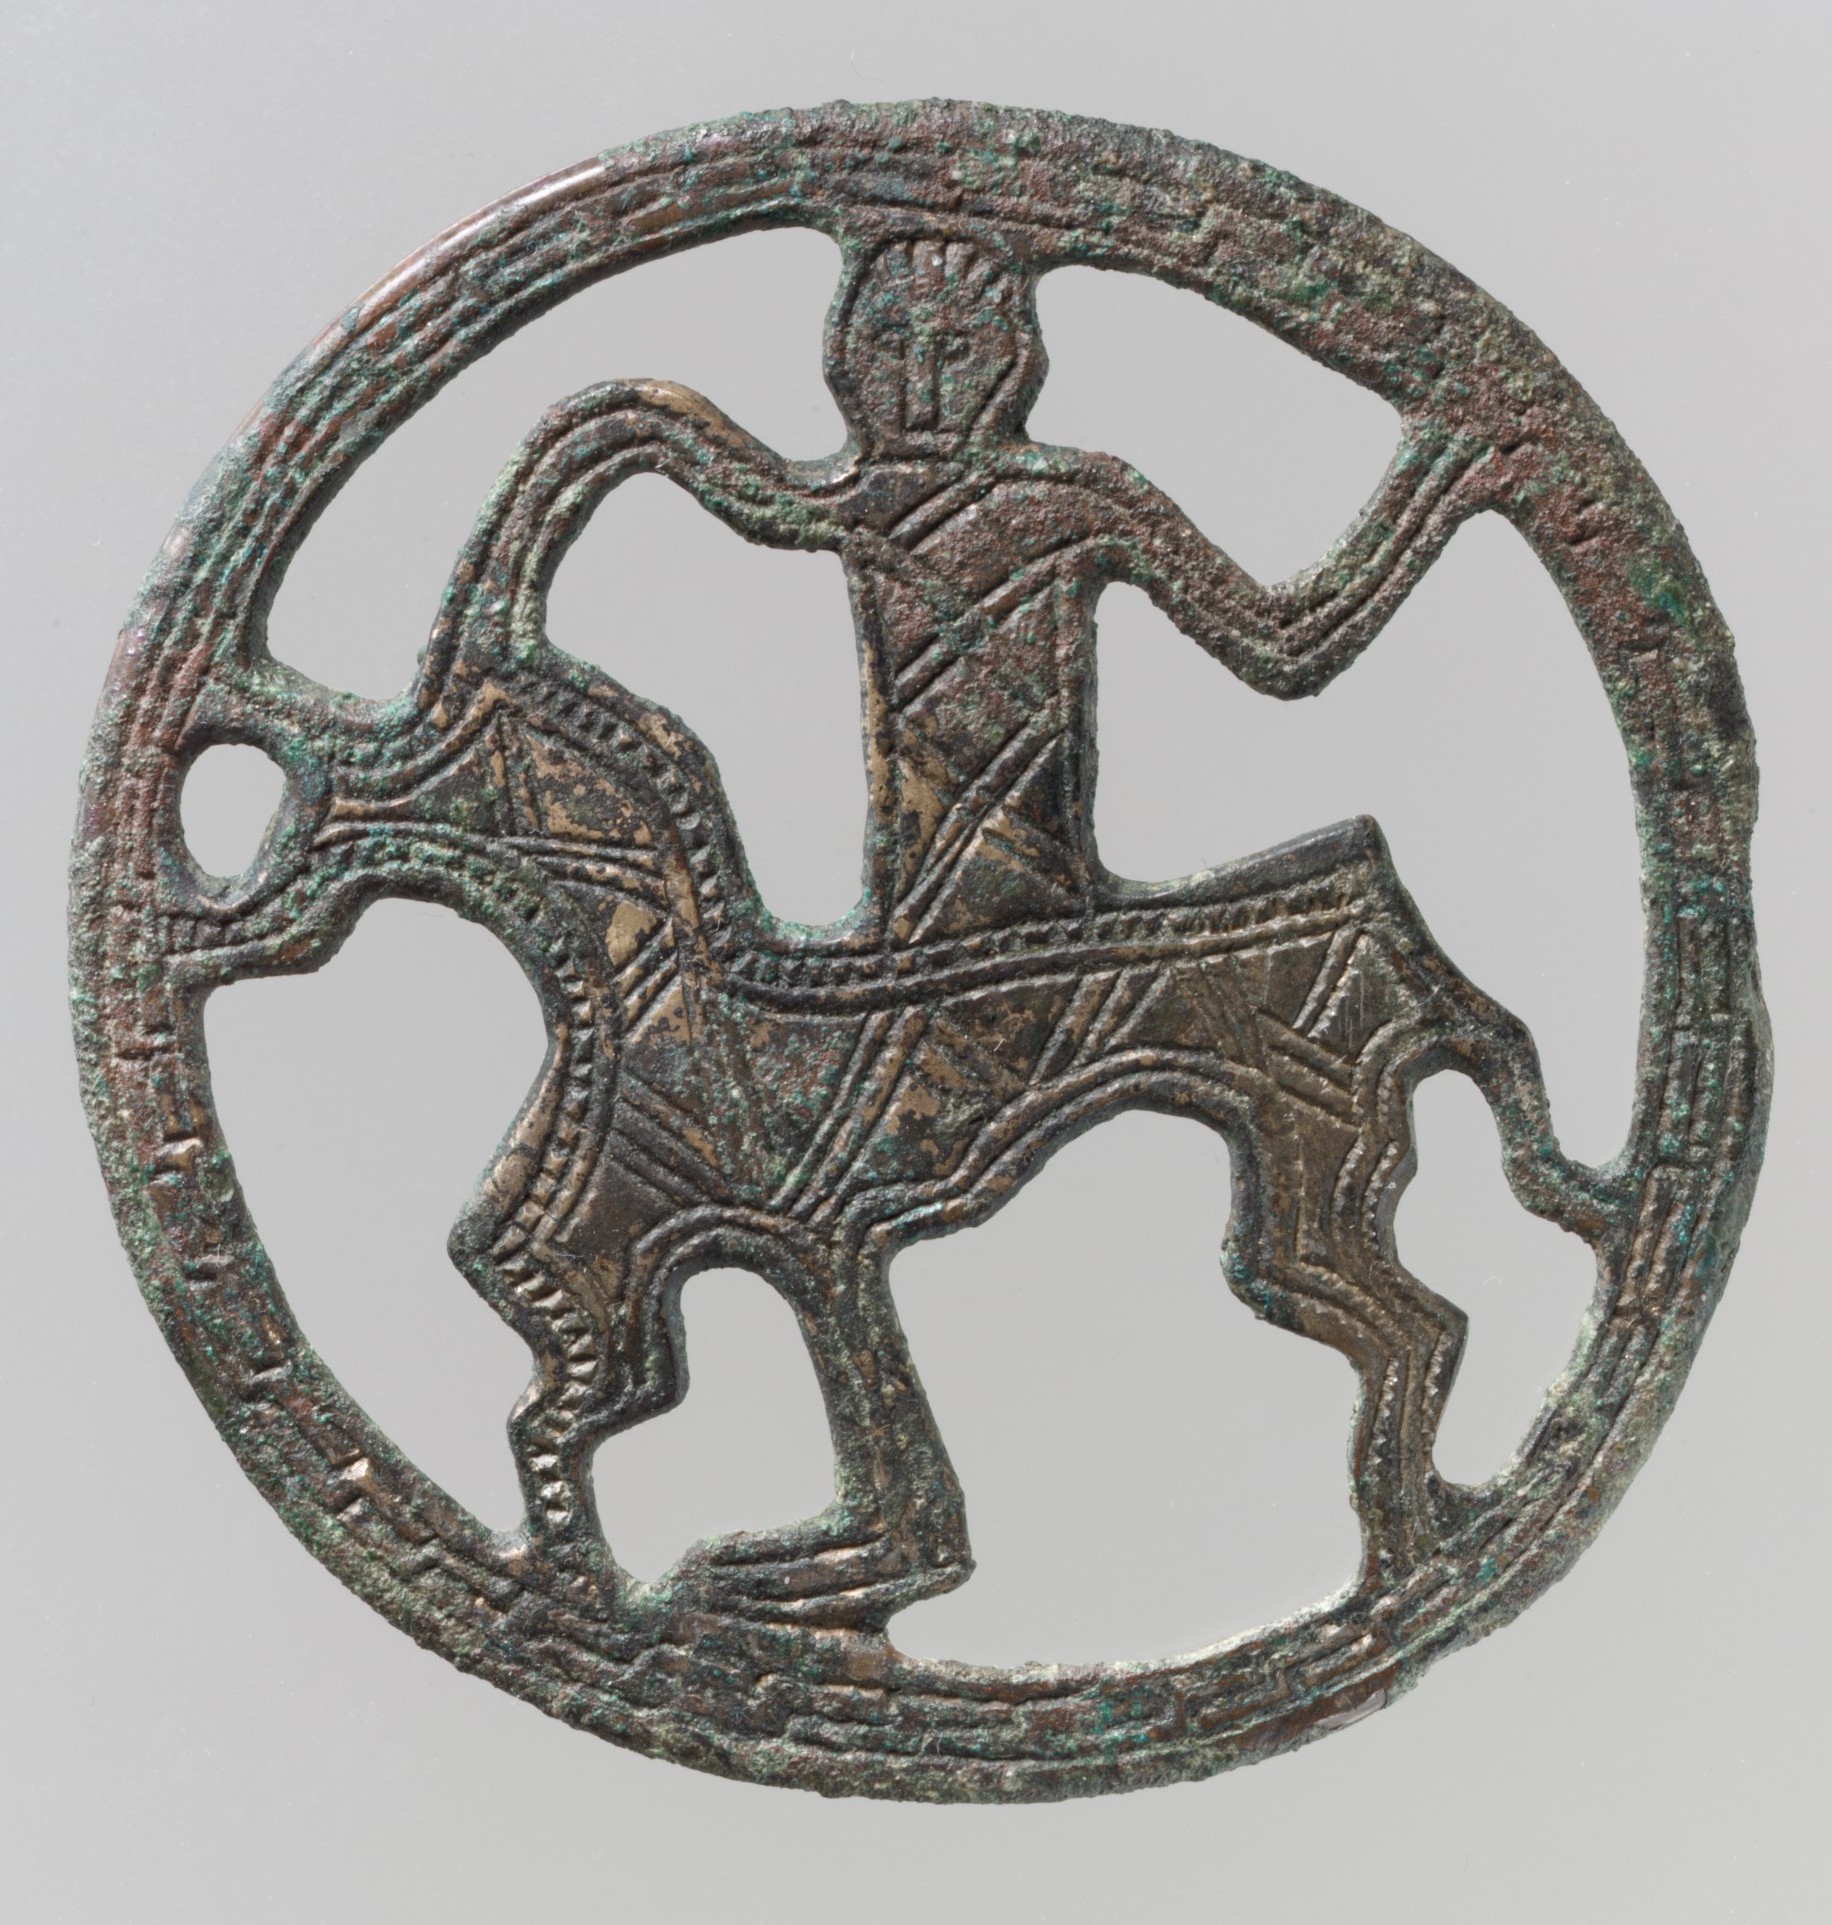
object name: disk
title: Openwork Belt Fitting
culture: frankish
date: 601-700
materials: copper alloy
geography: northern france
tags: human figures,horses